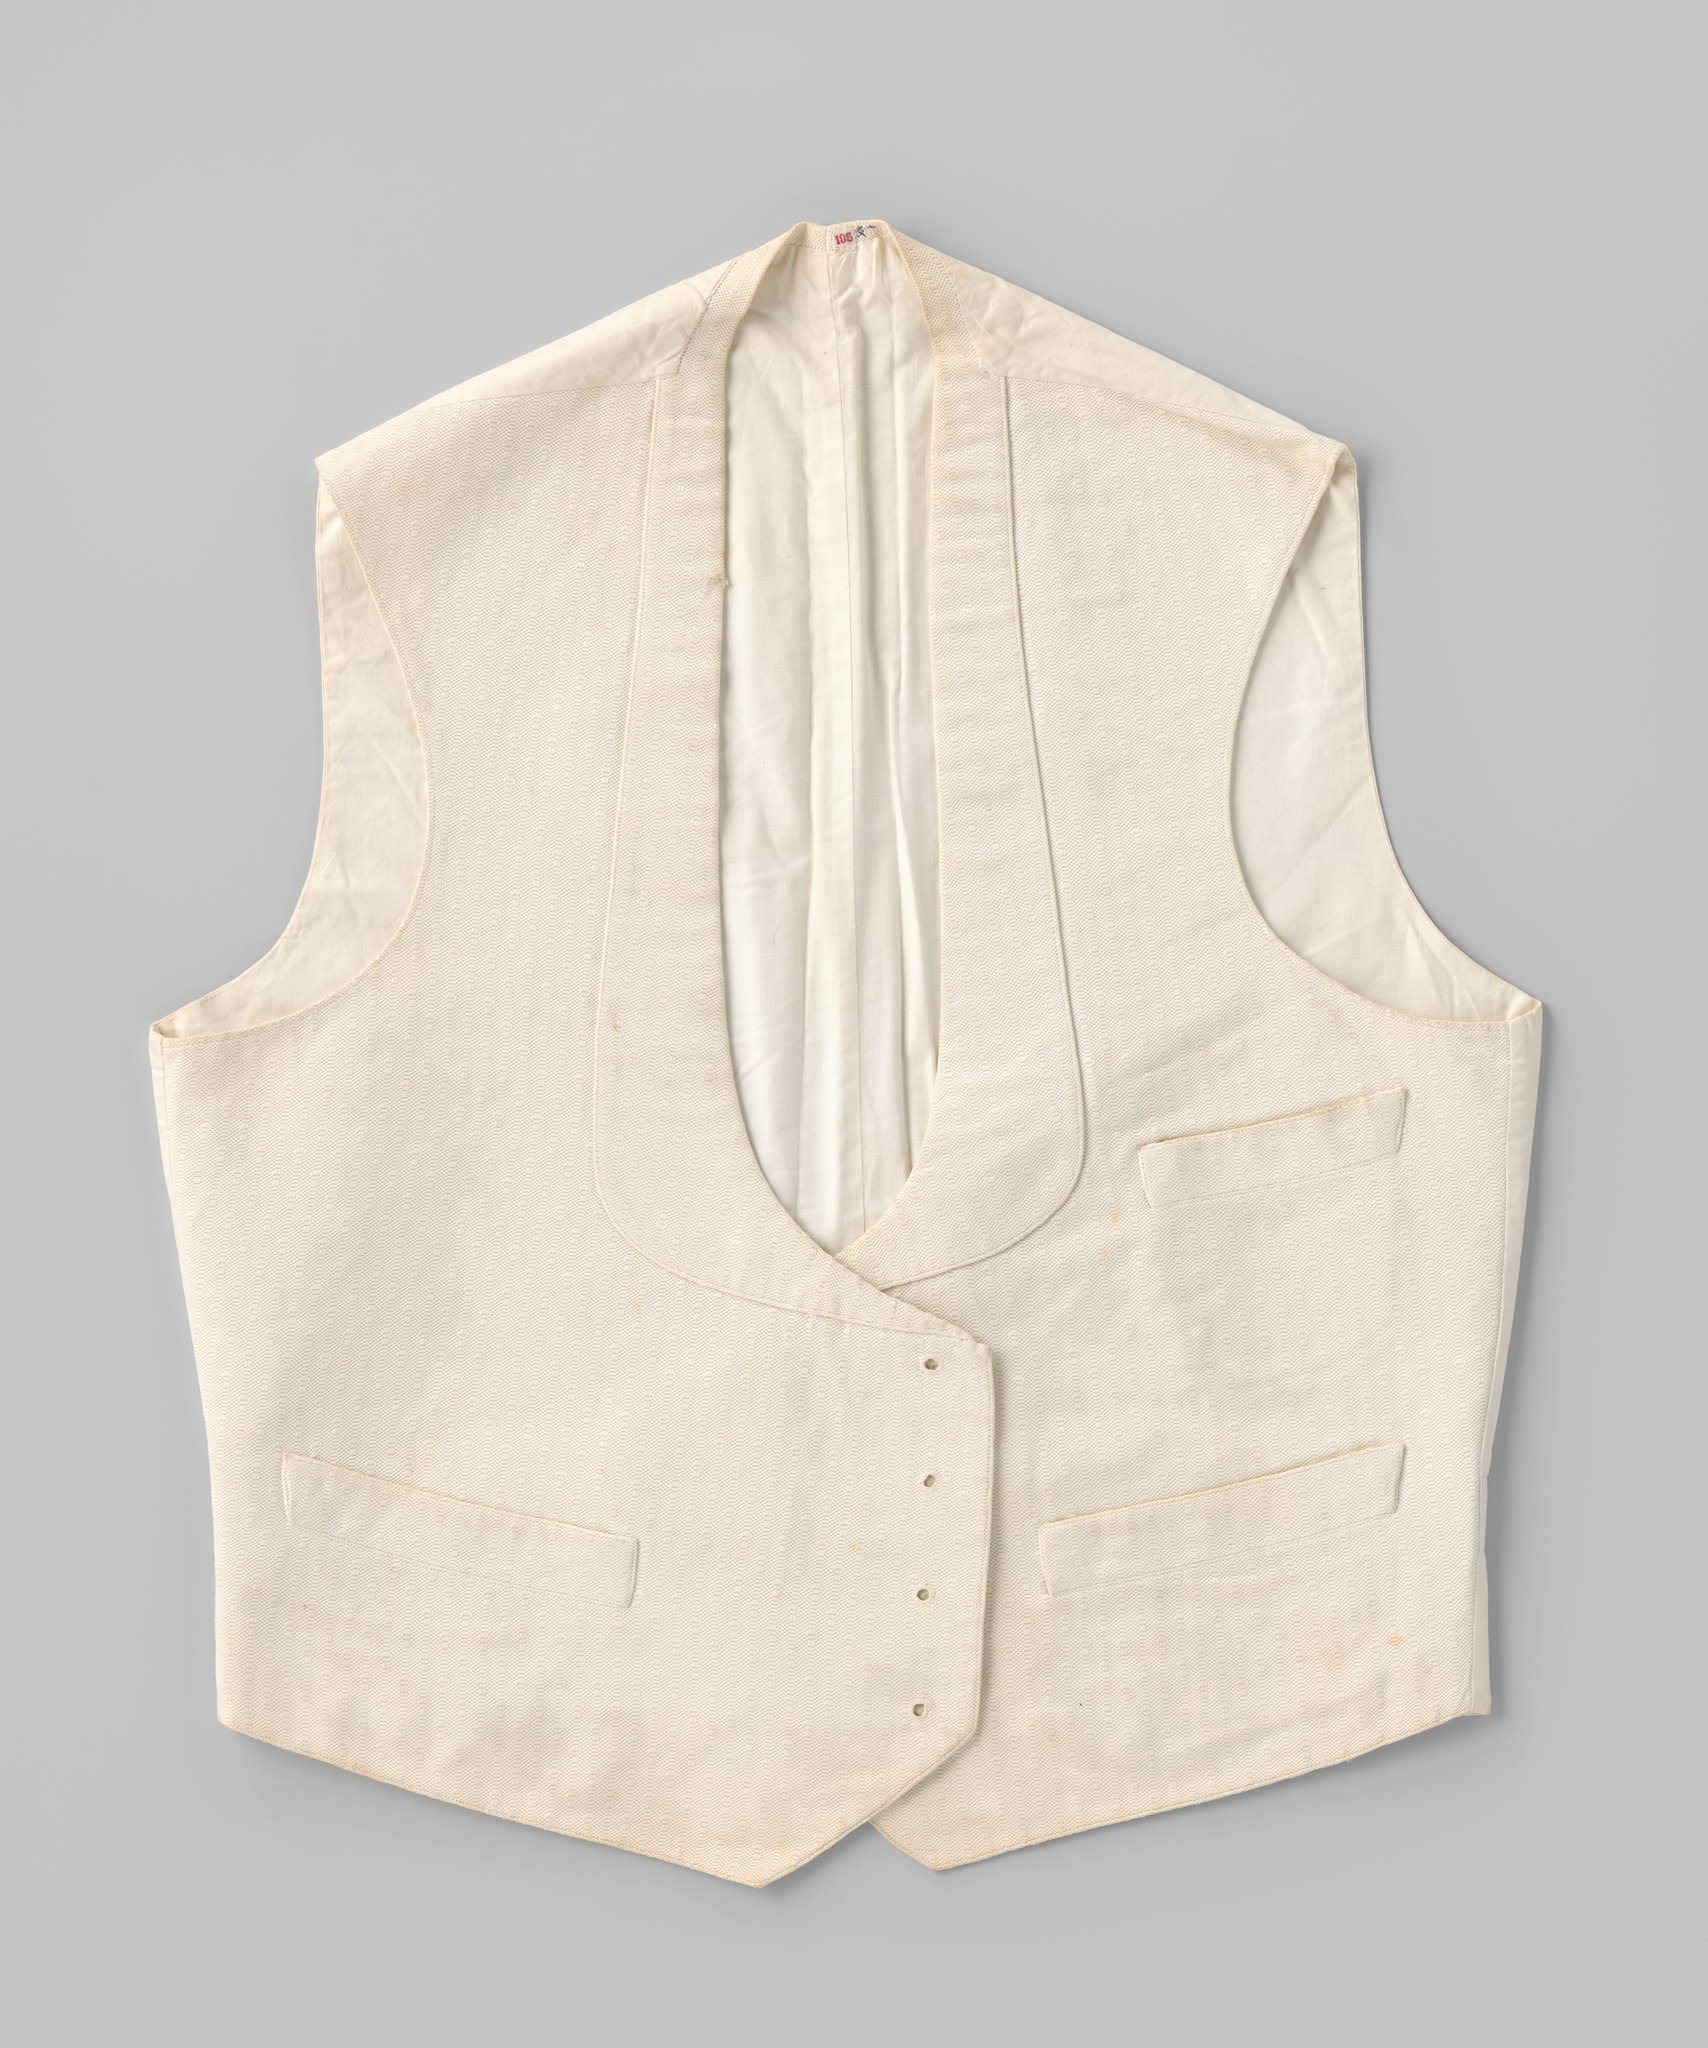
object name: rokvest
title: Rokvest van witte piqué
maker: Anonymous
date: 1920-1930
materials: textile